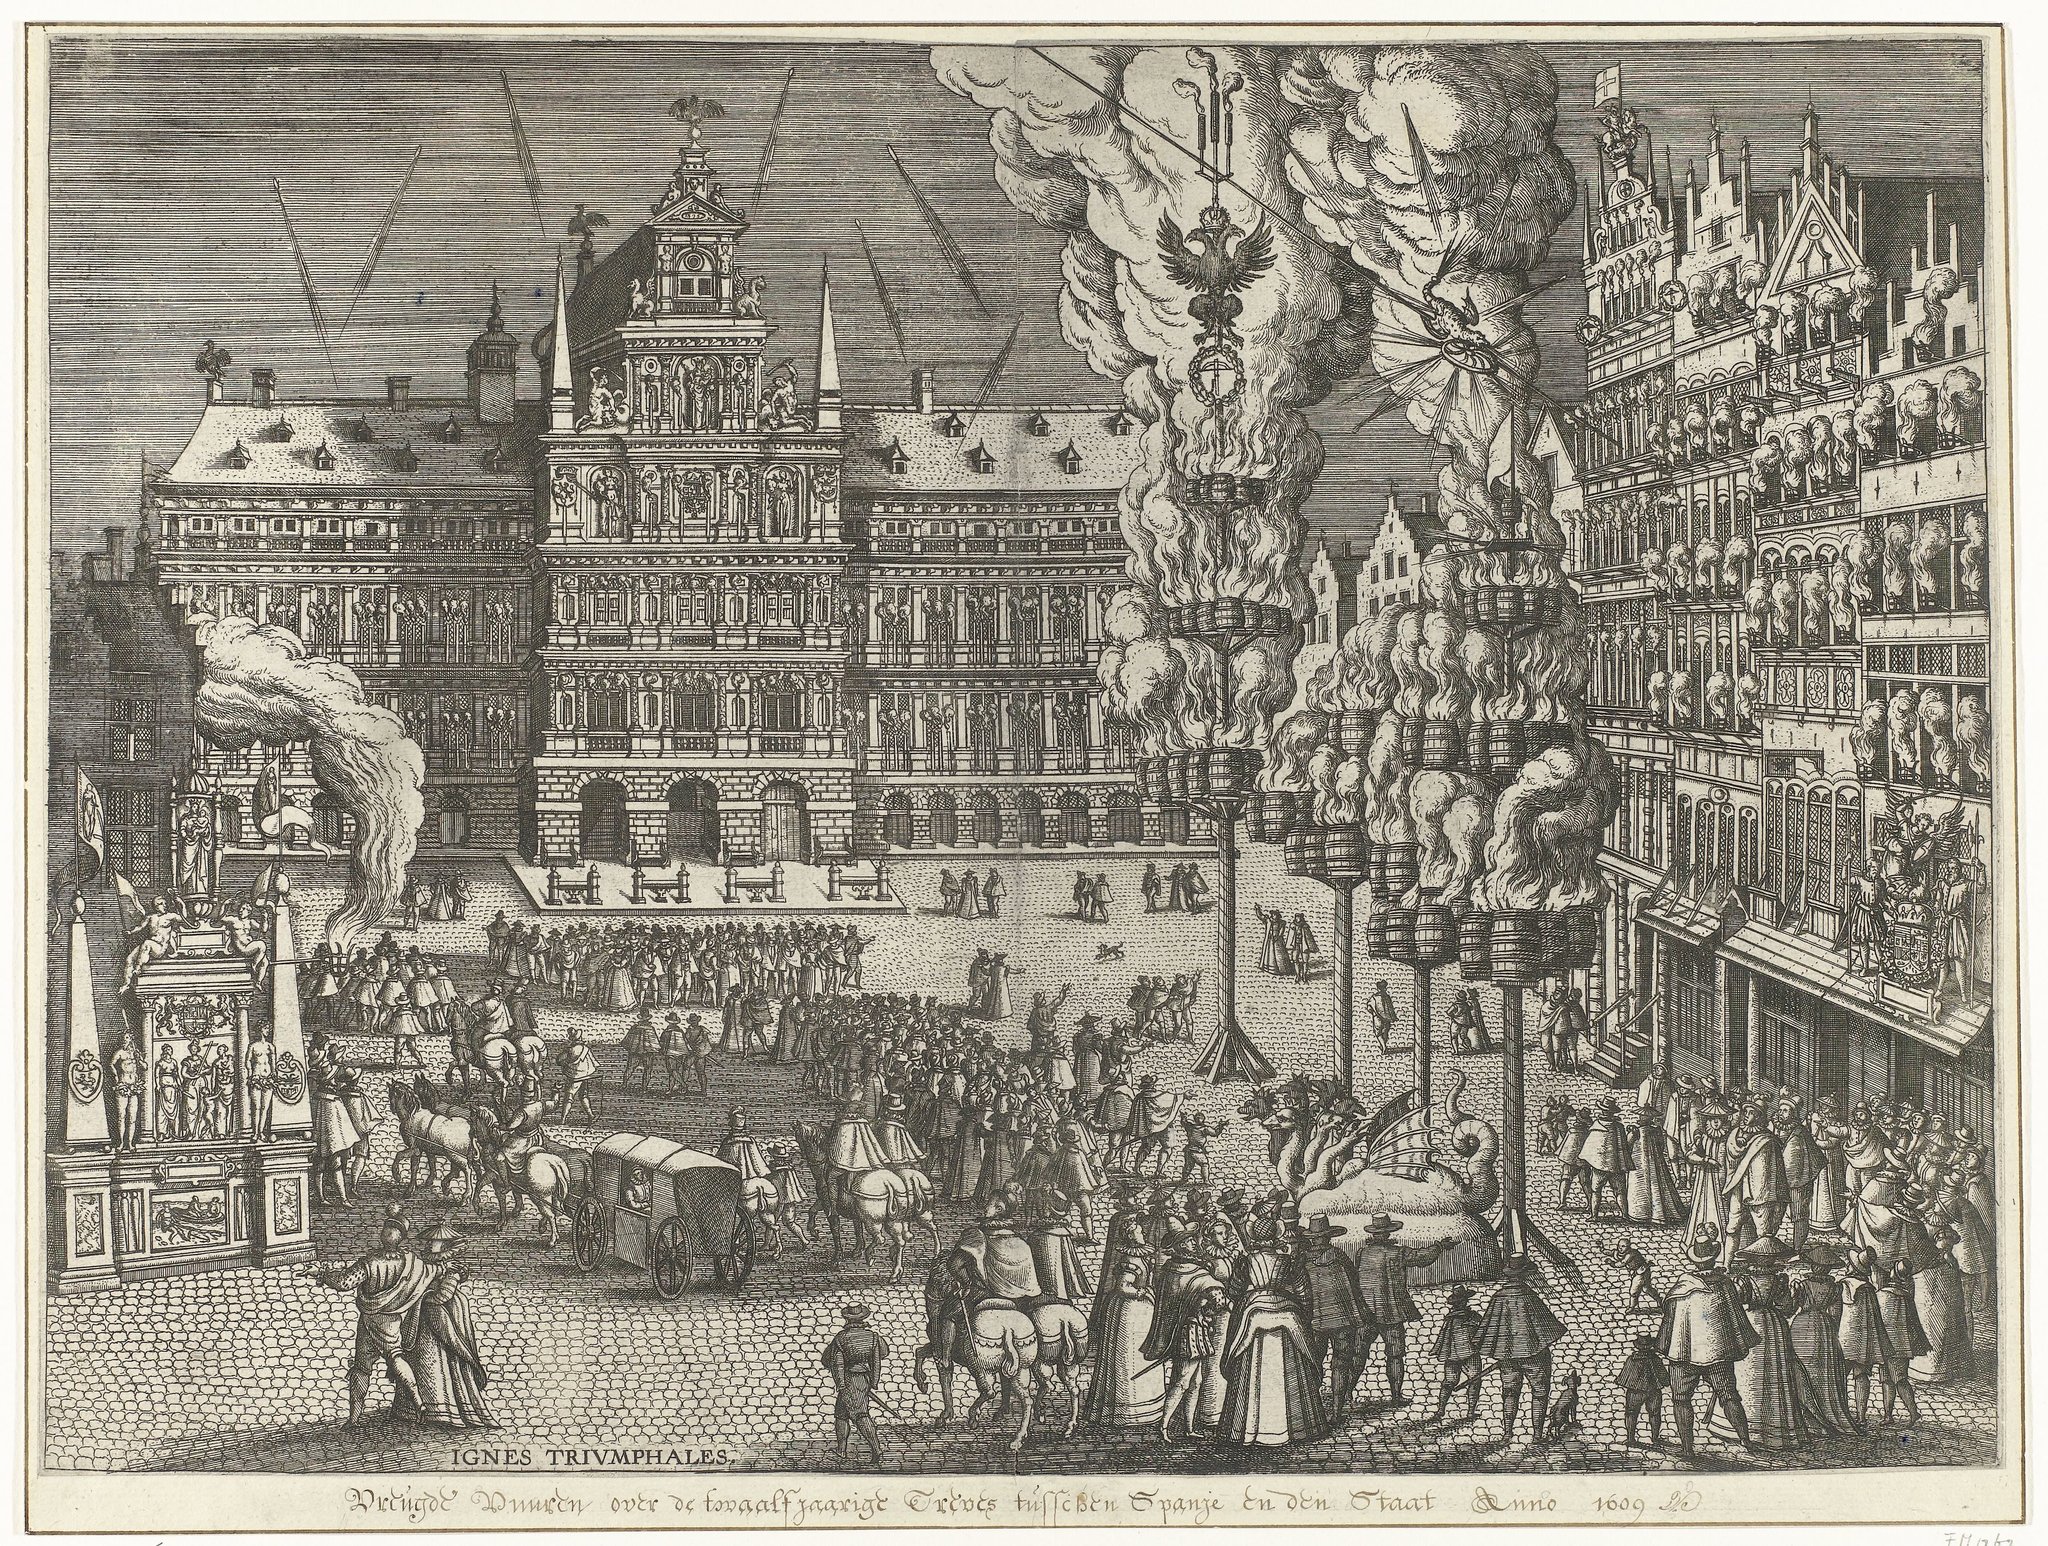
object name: print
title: Vreugde Vuuren over de twaalfjaarige Treves tusschen Spanje en den Staat Anno 1609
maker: pieter van der borcht (i)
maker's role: print maker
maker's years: 1545-1608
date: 1594-1595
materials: paper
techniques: etching, pen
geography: southern netherlands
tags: triumphal entry and public reception, pageant, 'entrée solennelle', 'joyeuse entrée', bonfire, fire-works, festivities on events of national importance (+ illumination, fire-works ~ festive activities), antwerp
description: Aankomst van aartshertog Ernst op de Grote Markt te Antwerpen, onderdeel van de beschrijving van de intocht van aartshertog Ernst te Antwerpen, 18 juli 1594. Deze voorstelling is door Muller eerst geïnterpreteerd als vreugdevuren en vuurwerk op de Grote Markt ter viering van het Twaalfjarig Bestand te Antwerpen, 14 april 1609.